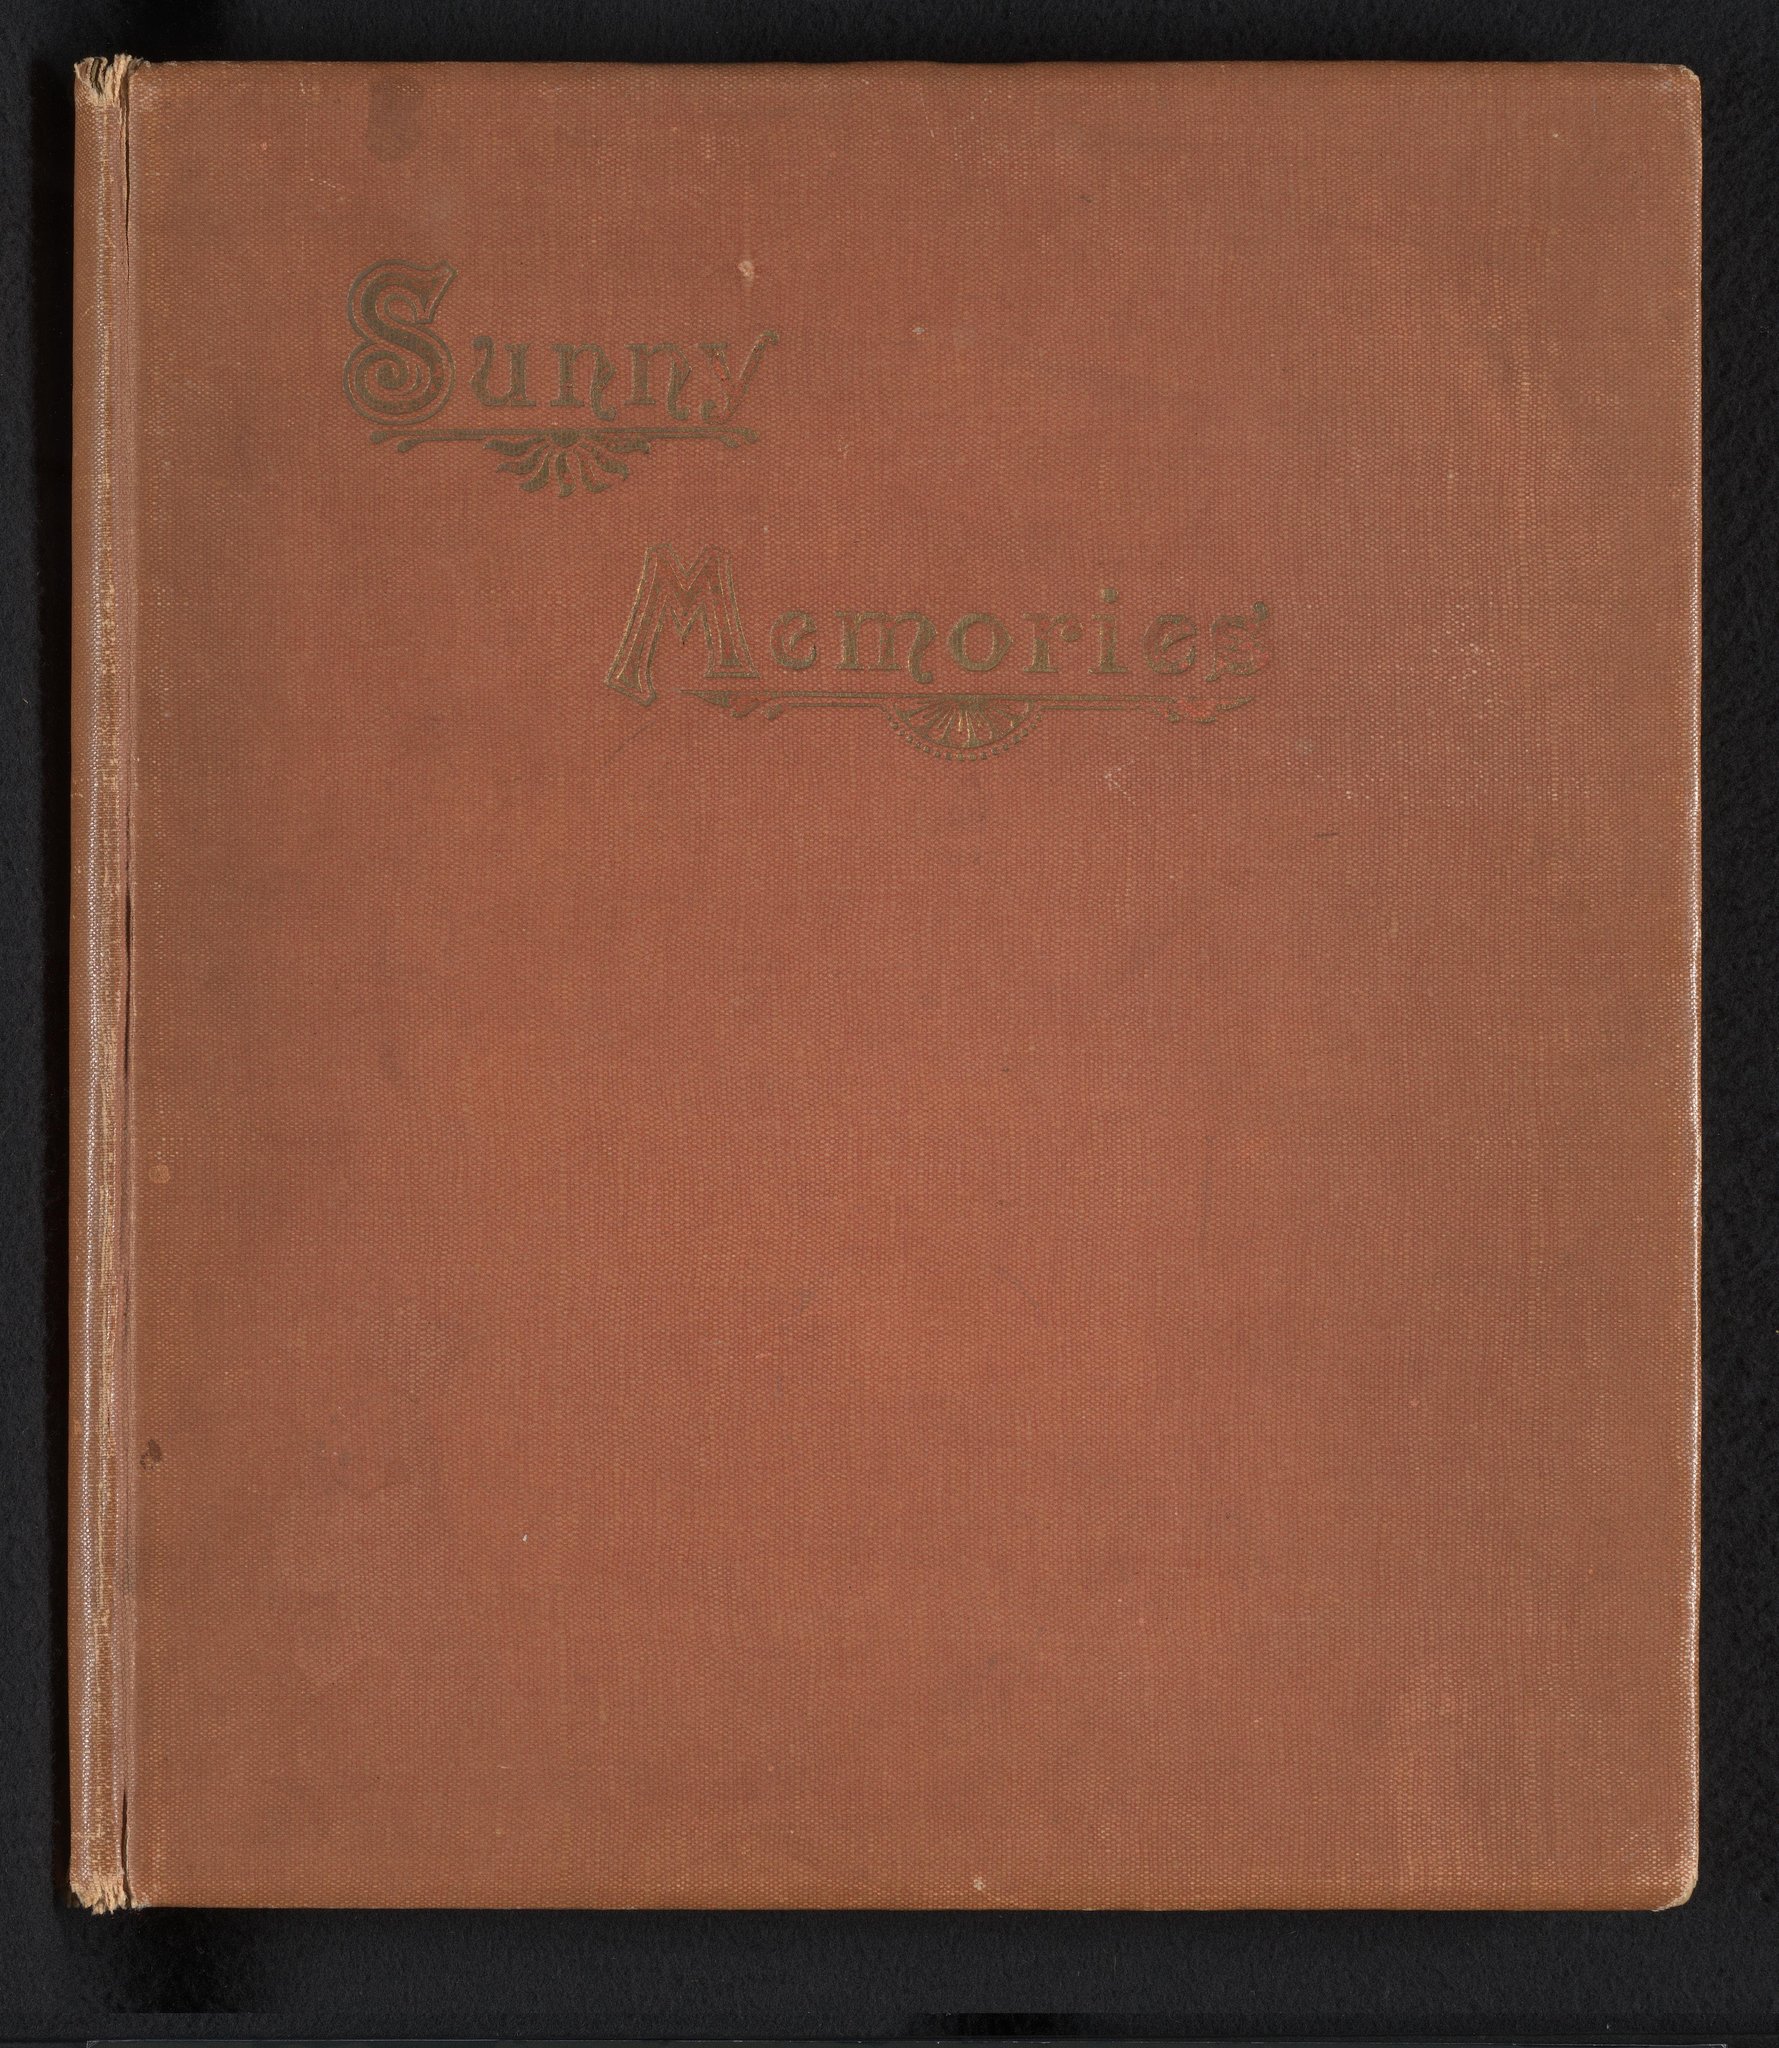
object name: slip in album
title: Fotoalbum met foto's van Machiel Gerrit George Suyver en omgeving, onder andere bij de H. & J. Suyver fabriek van stoomketels en werktuigen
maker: machiel gerrit george suyver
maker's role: fotograaf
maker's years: 1872-1933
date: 1890-1898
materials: paper, cardboard, linen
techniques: gelatin silver print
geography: netherlands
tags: h. & j. suyver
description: Insteekalbum met 138 foto's op 22 pagina's van Machiel Gerrit George Suyver en omgeving, onder andere bij de H. & J. Suyver fabriek van stoomketels en werktuigen.